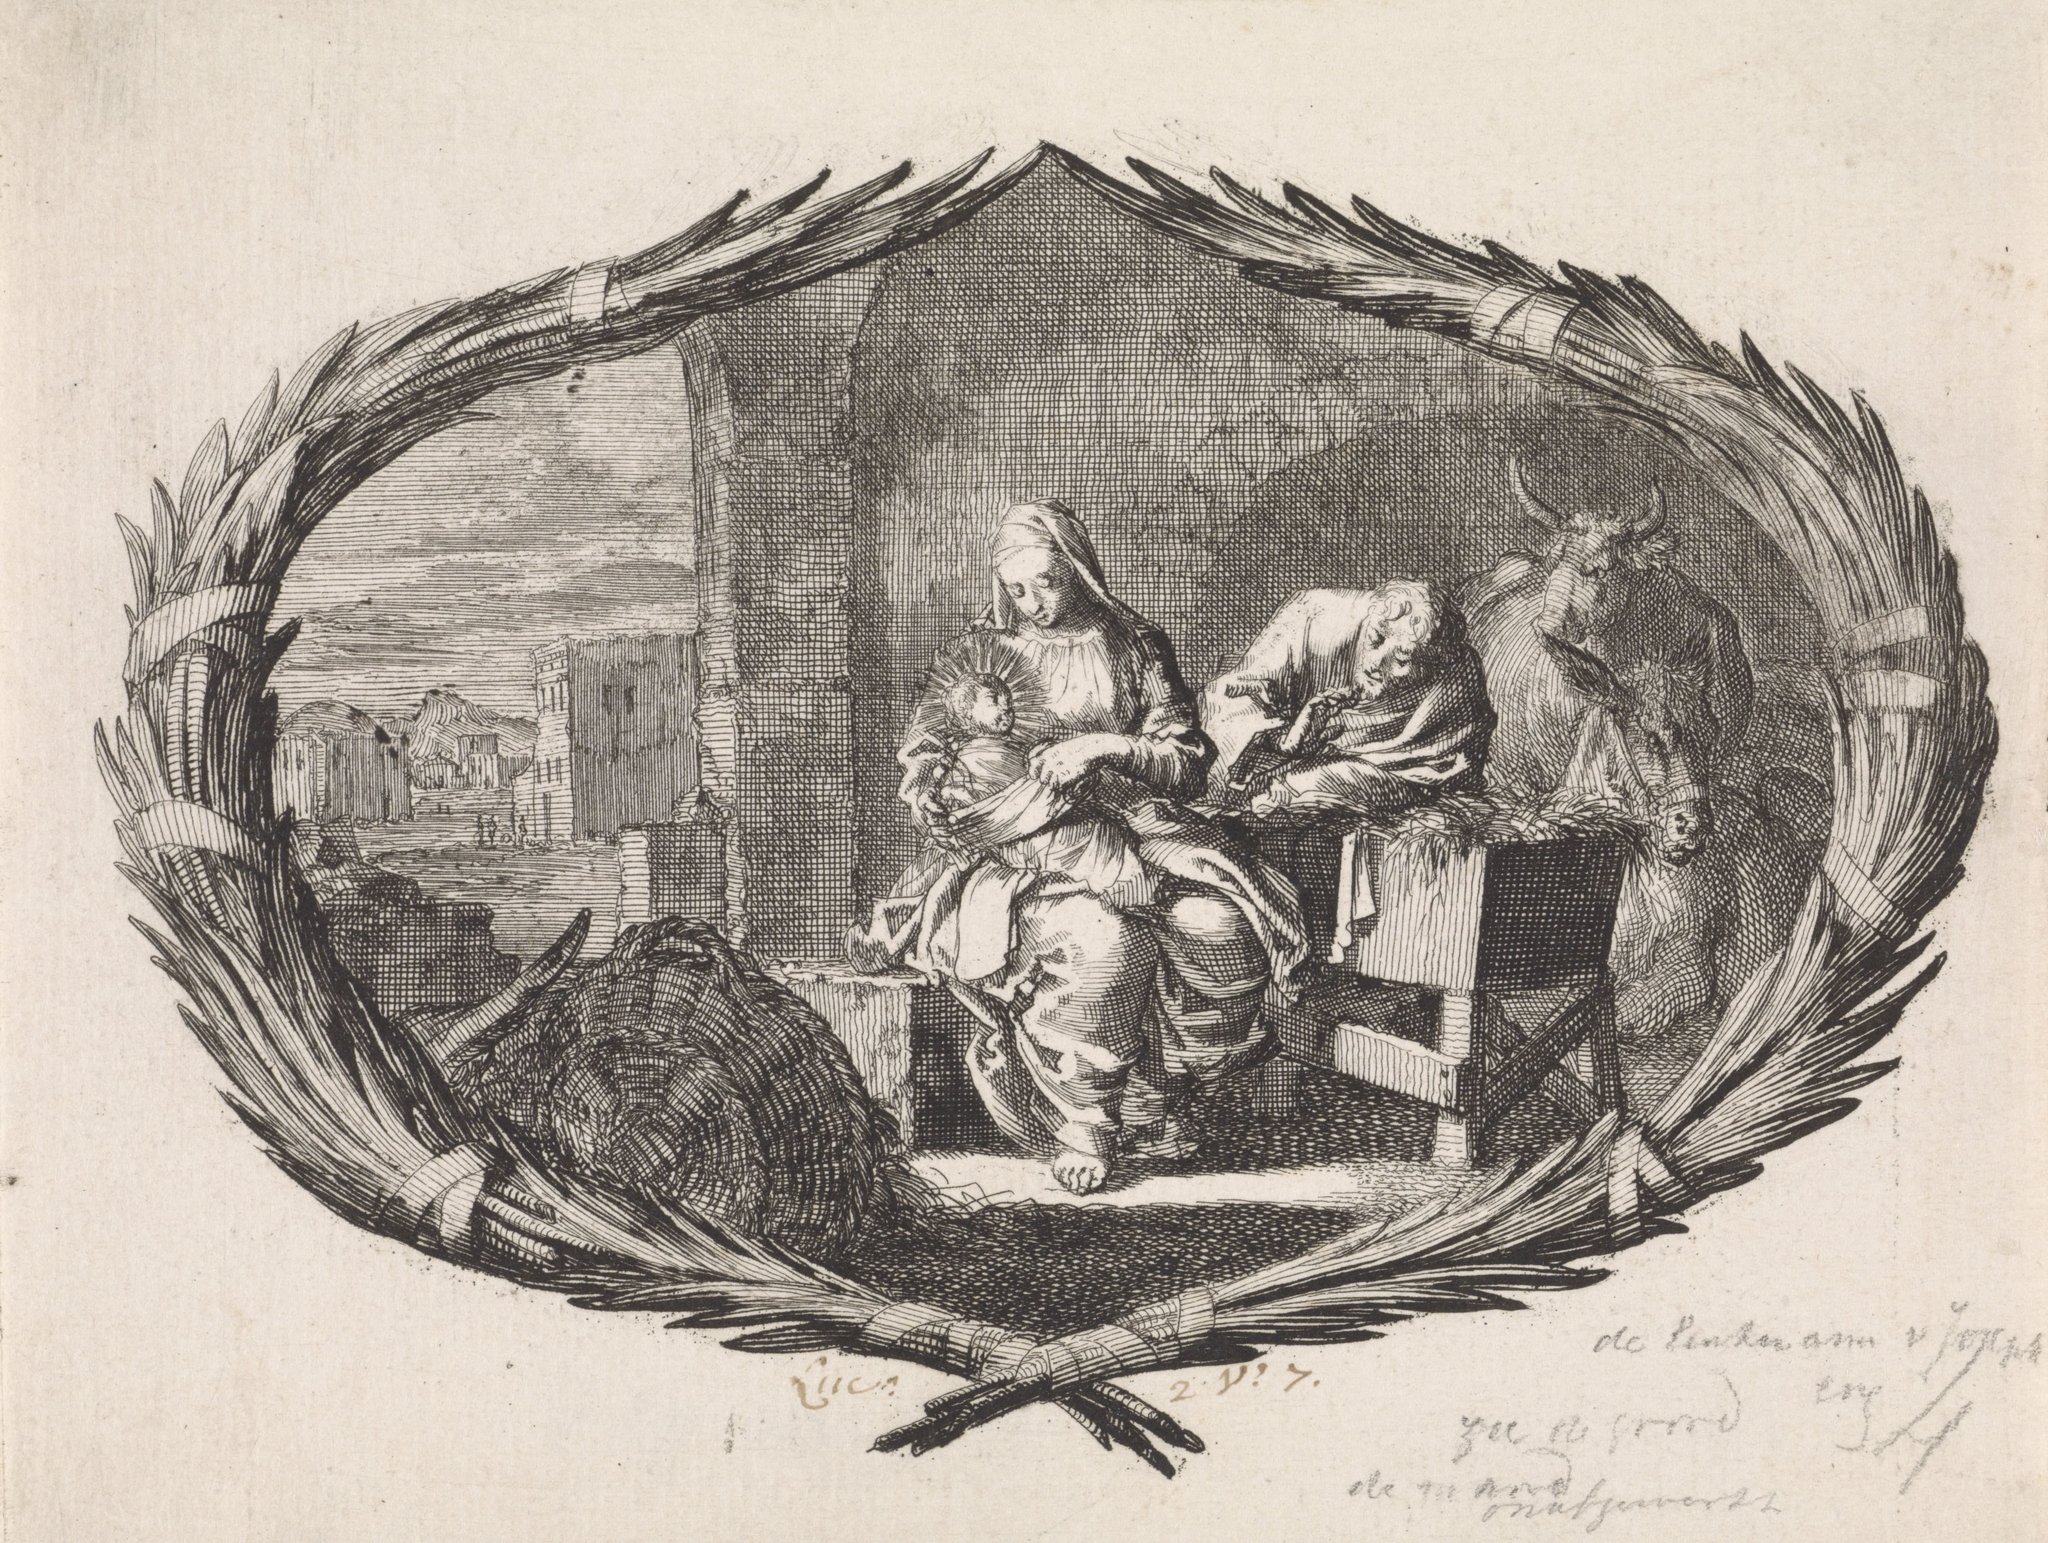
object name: print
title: Geboorte van Christus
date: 1700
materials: paper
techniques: etching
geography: amsterdam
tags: ornament ~ cartouche, mary, joseph and the new-born christ (nativity)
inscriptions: inscription: ‘Luc. 2 vs. 7’, collector's mark: Lugt 2228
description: Proefdruk van een boekillustratie voor David Martin. Historie des Ouden en Nieuwen Testaments, verrykt met meer dan vierhonderd printverbeeldingen. Deel II. Amsterdam: Pieter Mortier, 1700.